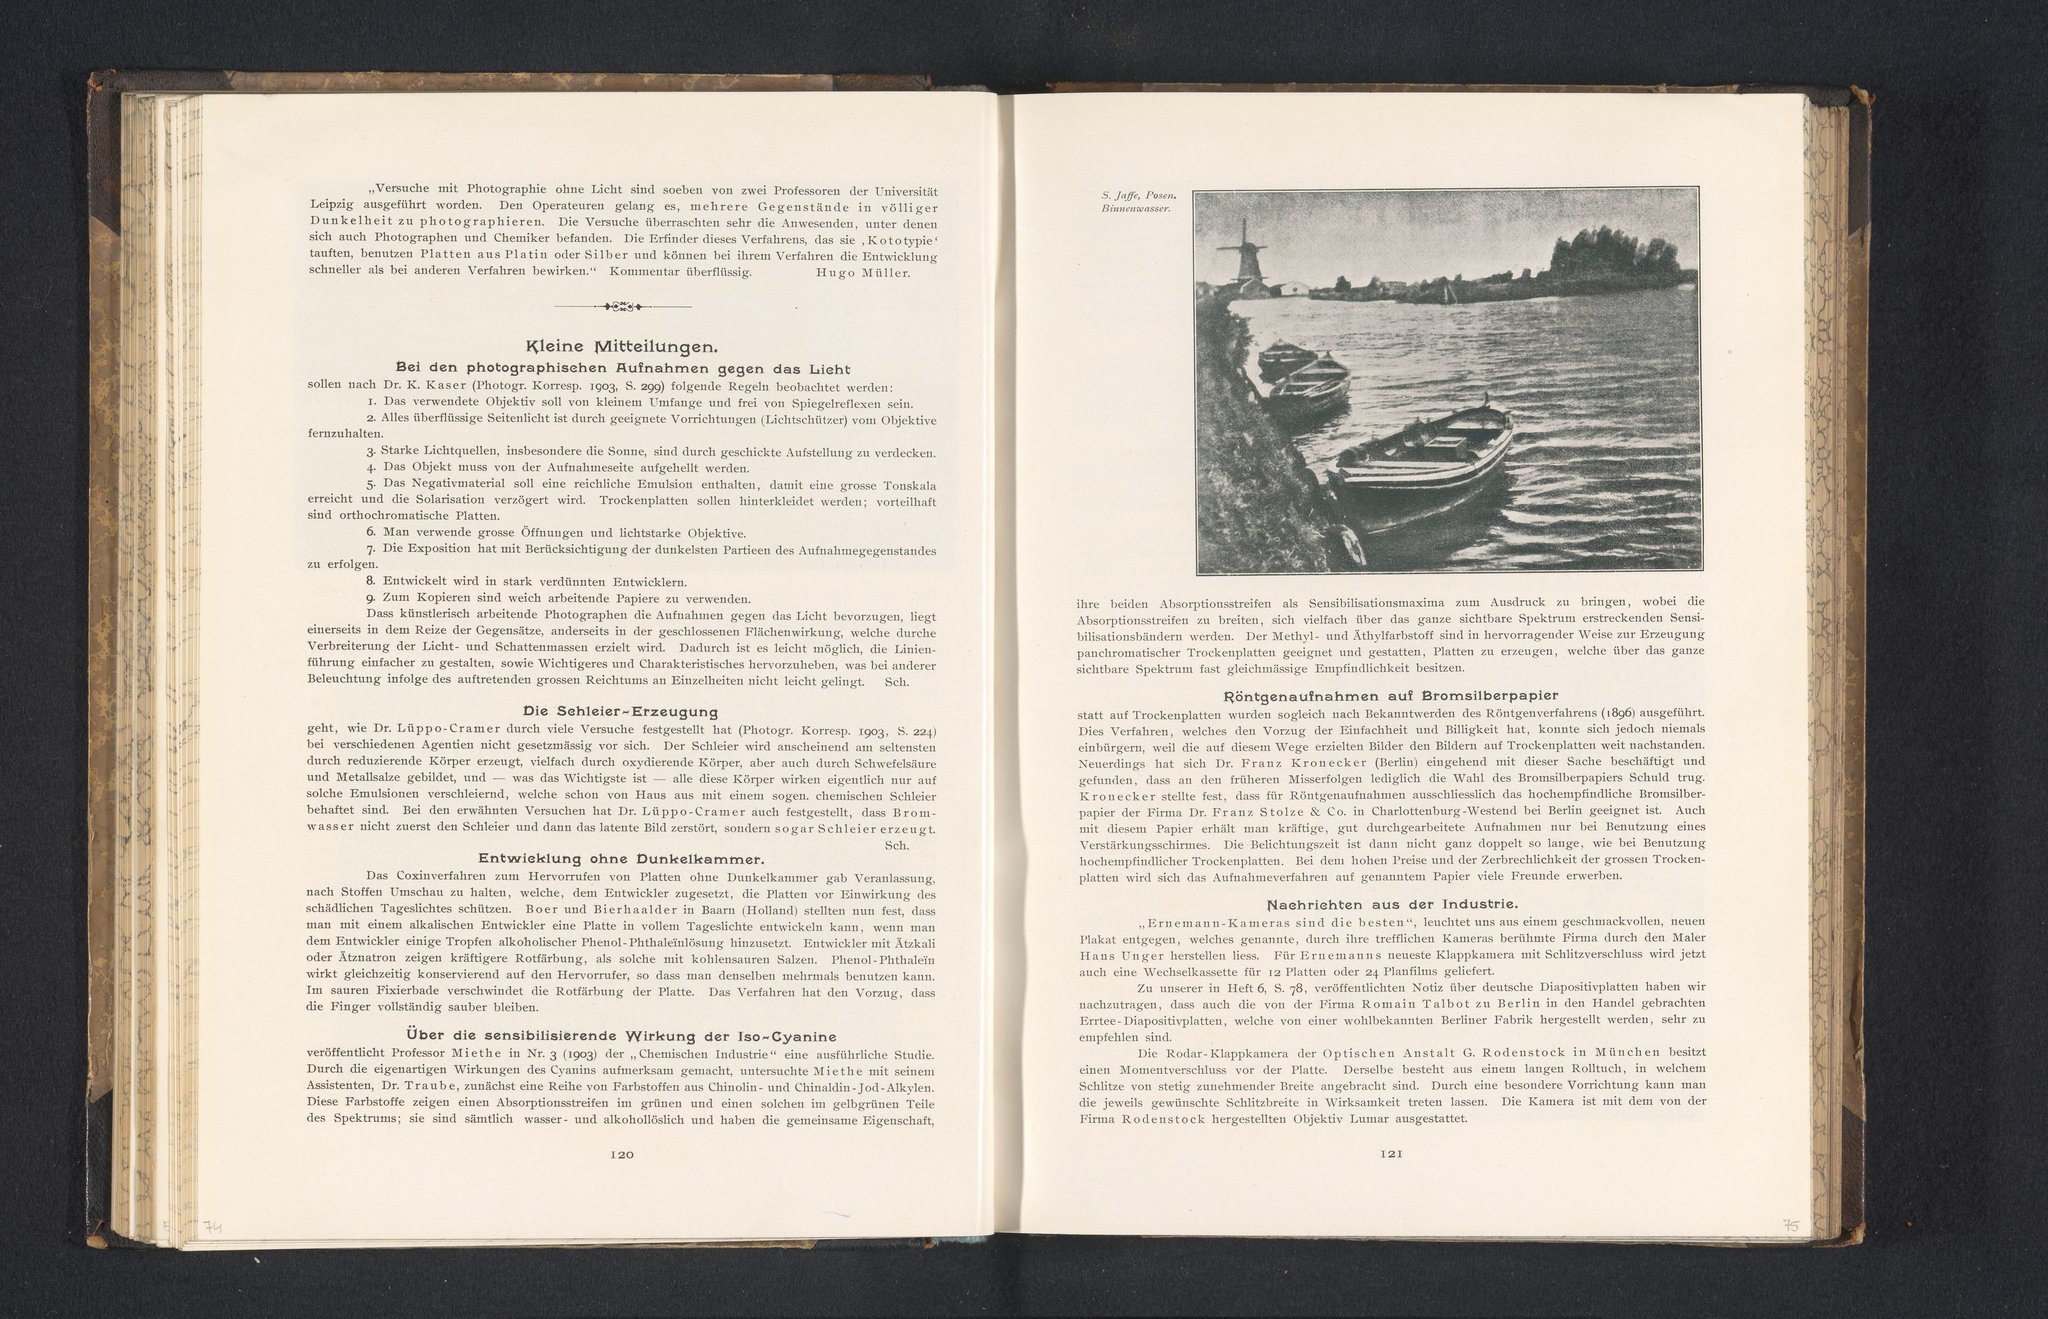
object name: page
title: Binnenwasser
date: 1898-1903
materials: paper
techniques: autotype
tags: river, rowing-boat, canoe, etc.